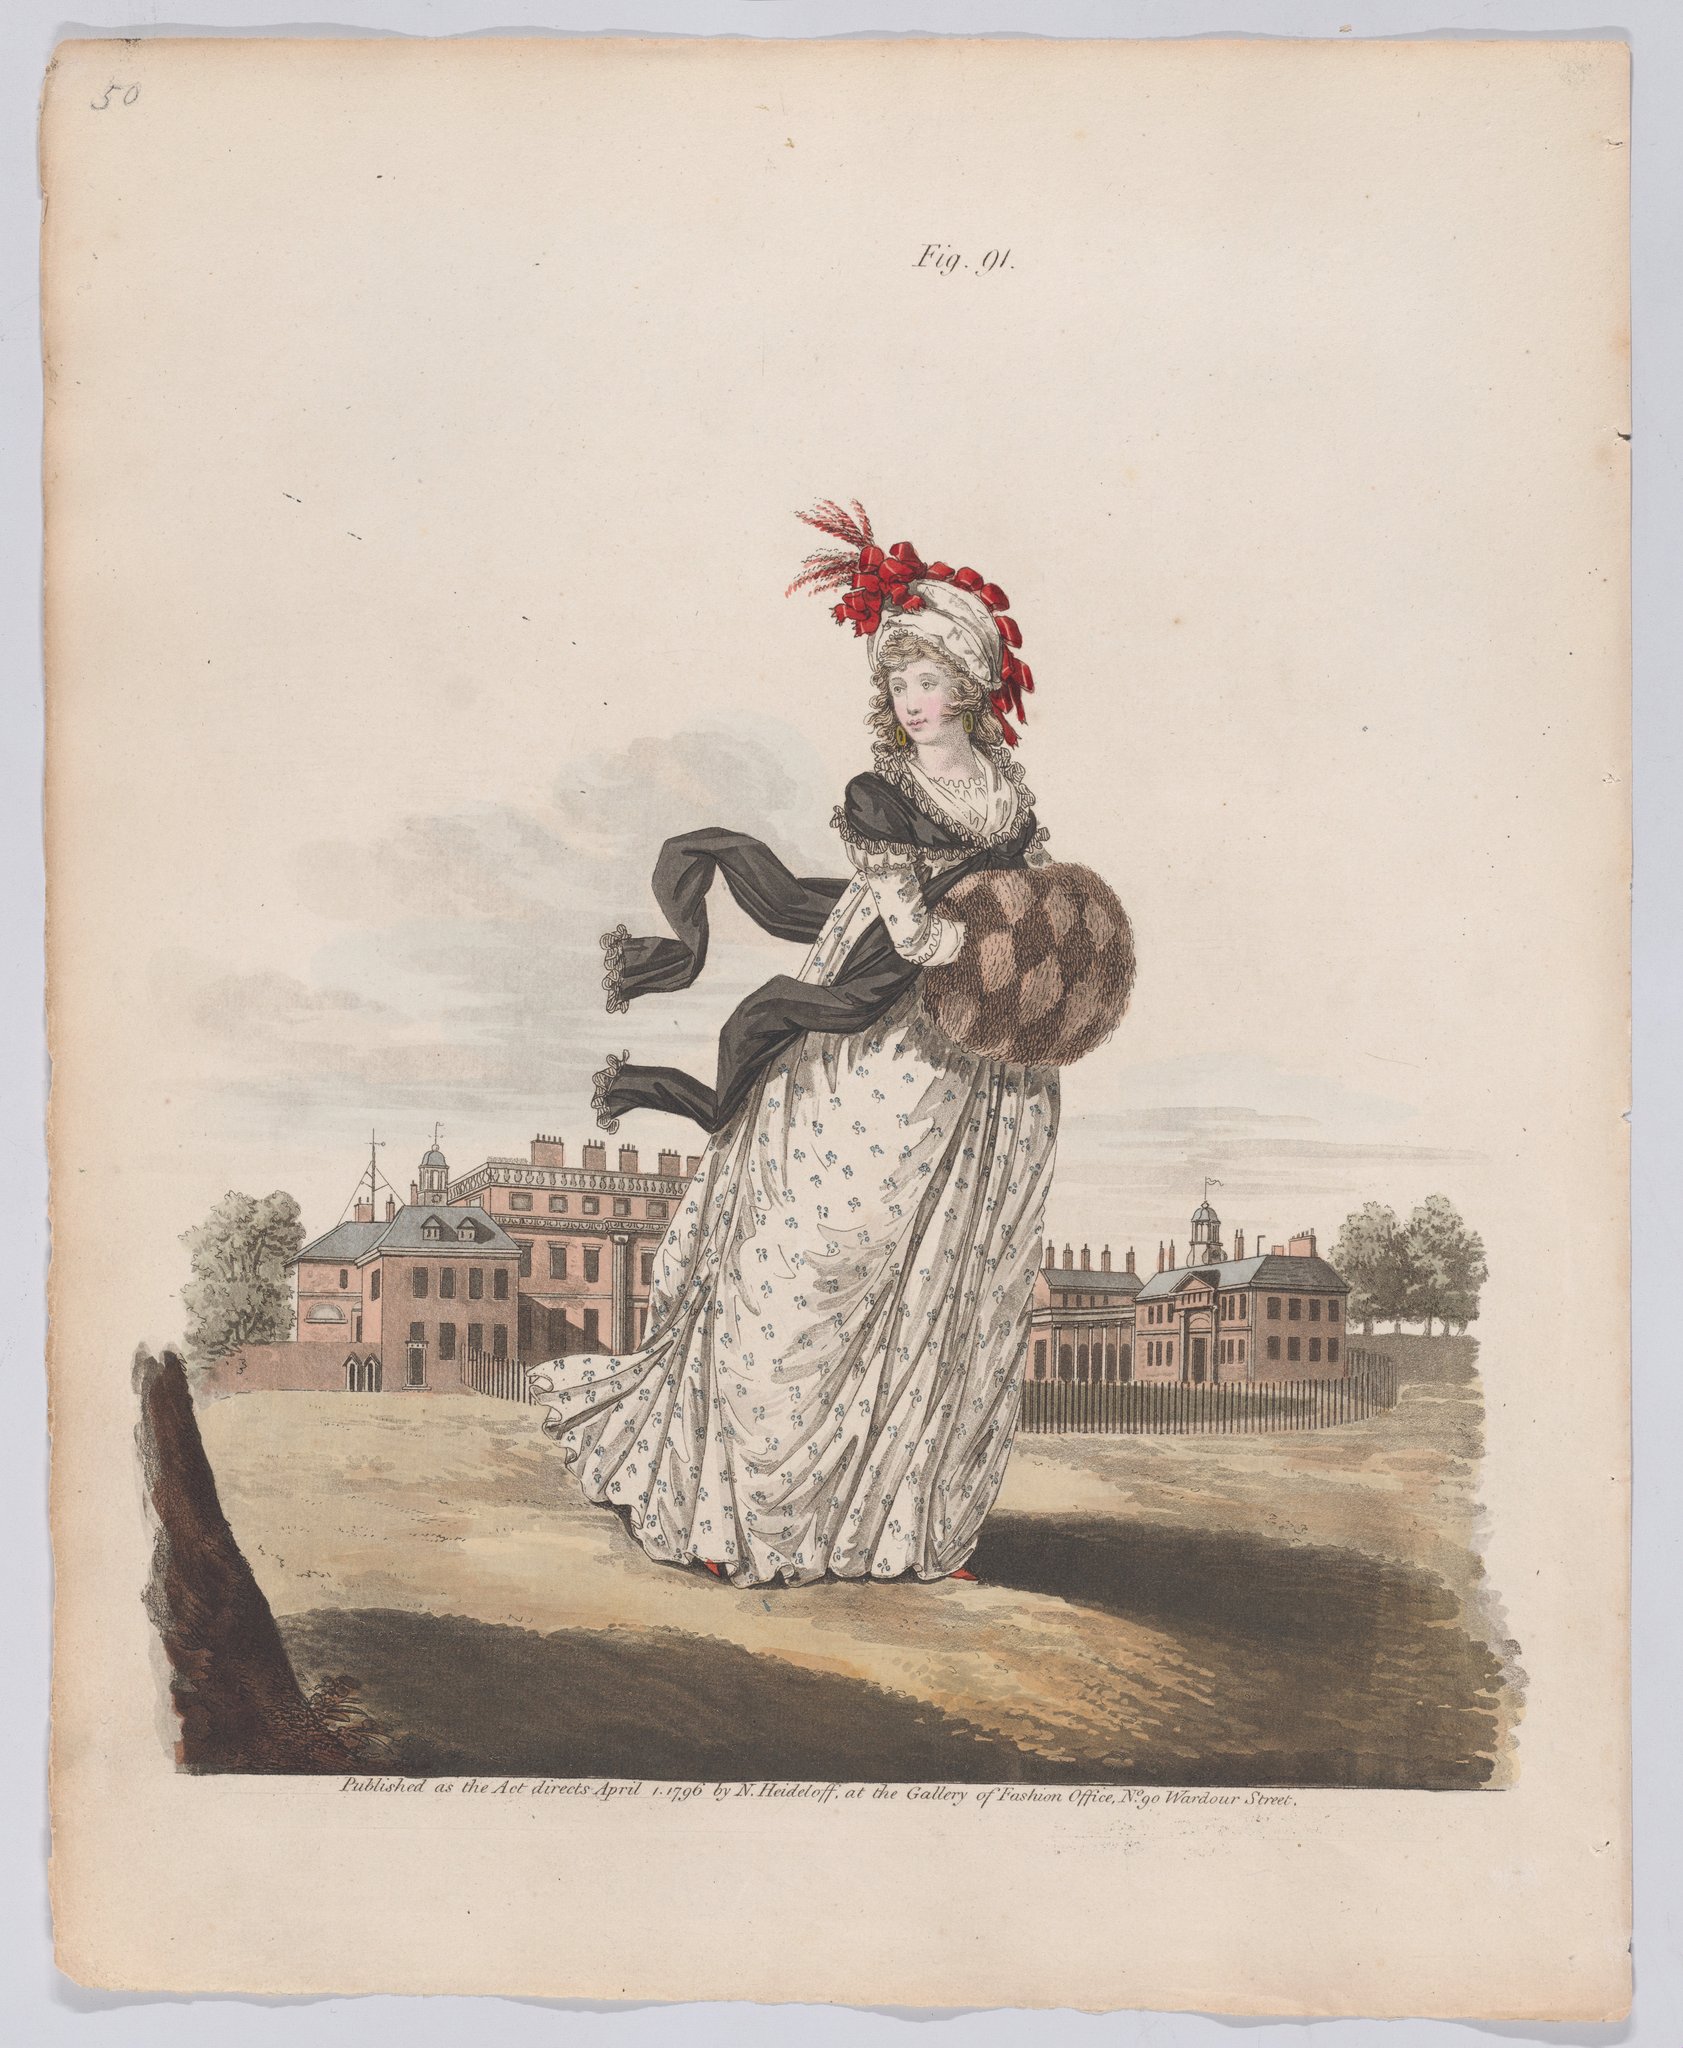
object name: book costume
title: Gallery of Fashion, vol. III: April 1 1796 - March 1 1797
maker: nicolaus heideloff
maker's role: publisher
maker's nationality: british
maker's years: 1761-1837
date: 1794-1802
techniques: engraving, etching, hand coloring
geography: england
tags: women,fashion